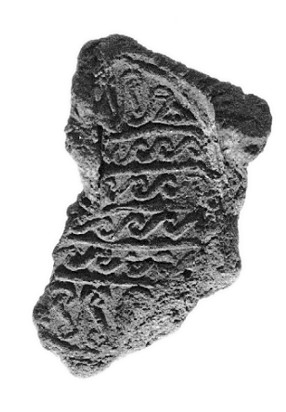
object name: sealing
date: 1981-1640 BCE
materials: mud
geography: egypt